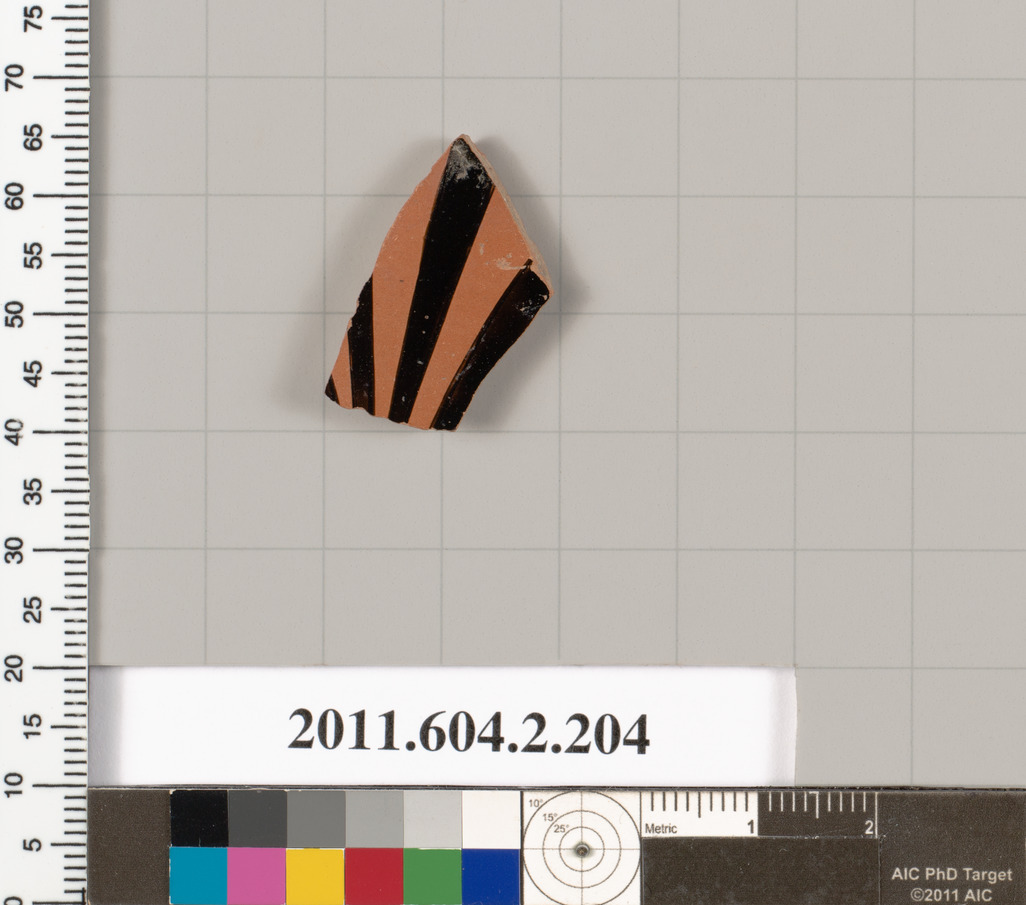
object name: stamnos fragment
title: Terracotta fragment of a stamnos (jar)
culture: greek, attic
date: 510-490 BCE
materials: terracotta